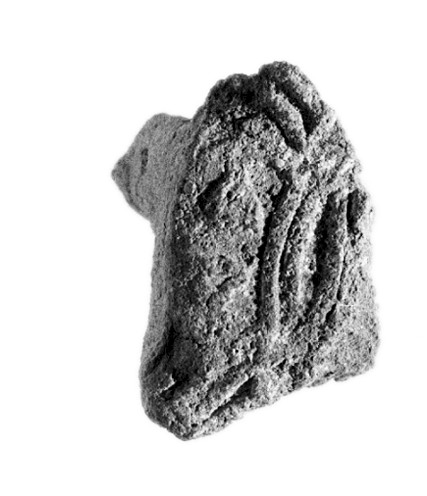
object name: sealing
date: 1981-1640 BCE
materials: mud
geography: egypt